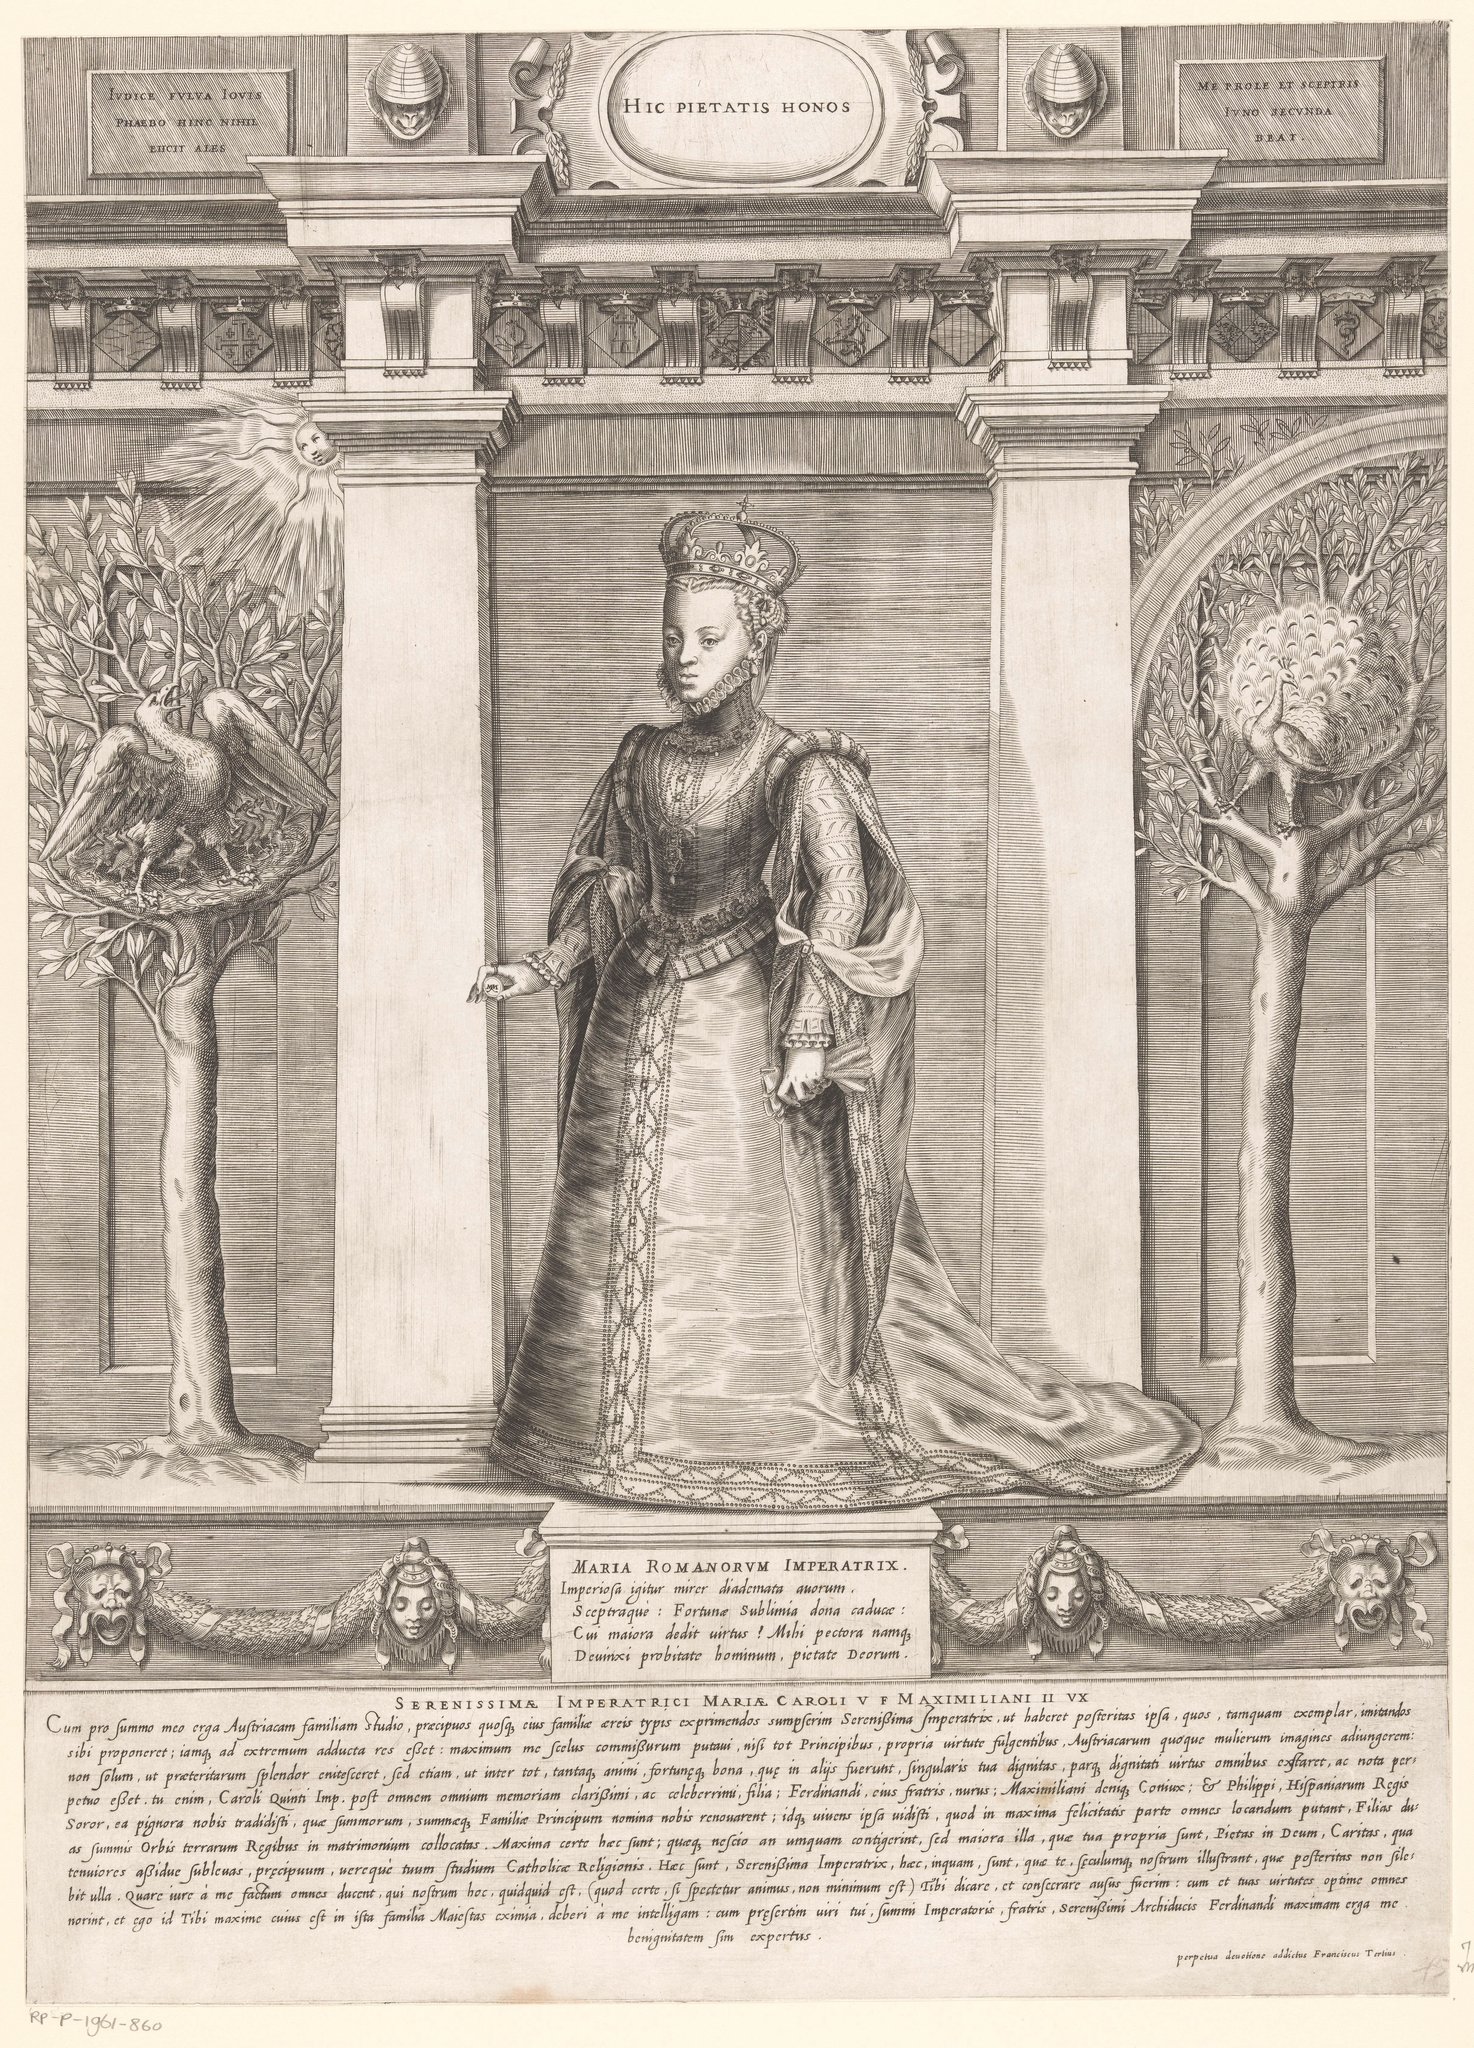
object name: print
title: Portret van Maria van Spanje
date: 1569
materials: paper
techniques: engraving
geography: italy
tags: maria (koningin van bohemen), historical persons - bb - woman, ruler, sovereign - bb - female ruler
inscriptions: collector's mark: Lugt 2228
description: Deze prent maakt deel uit van een reeks van 58 prenten. Het meerendeel van de prenten bevat portretten van 74 leden van het Oostenrijkse Huis, naar tekeningen door Francesco Terzio, die deels getekend zijn naar de 28 levensgrote bronzen beelden die rond de cenotaaf van Maximiliaan I in de Hofkirche te Innsbruck staan.